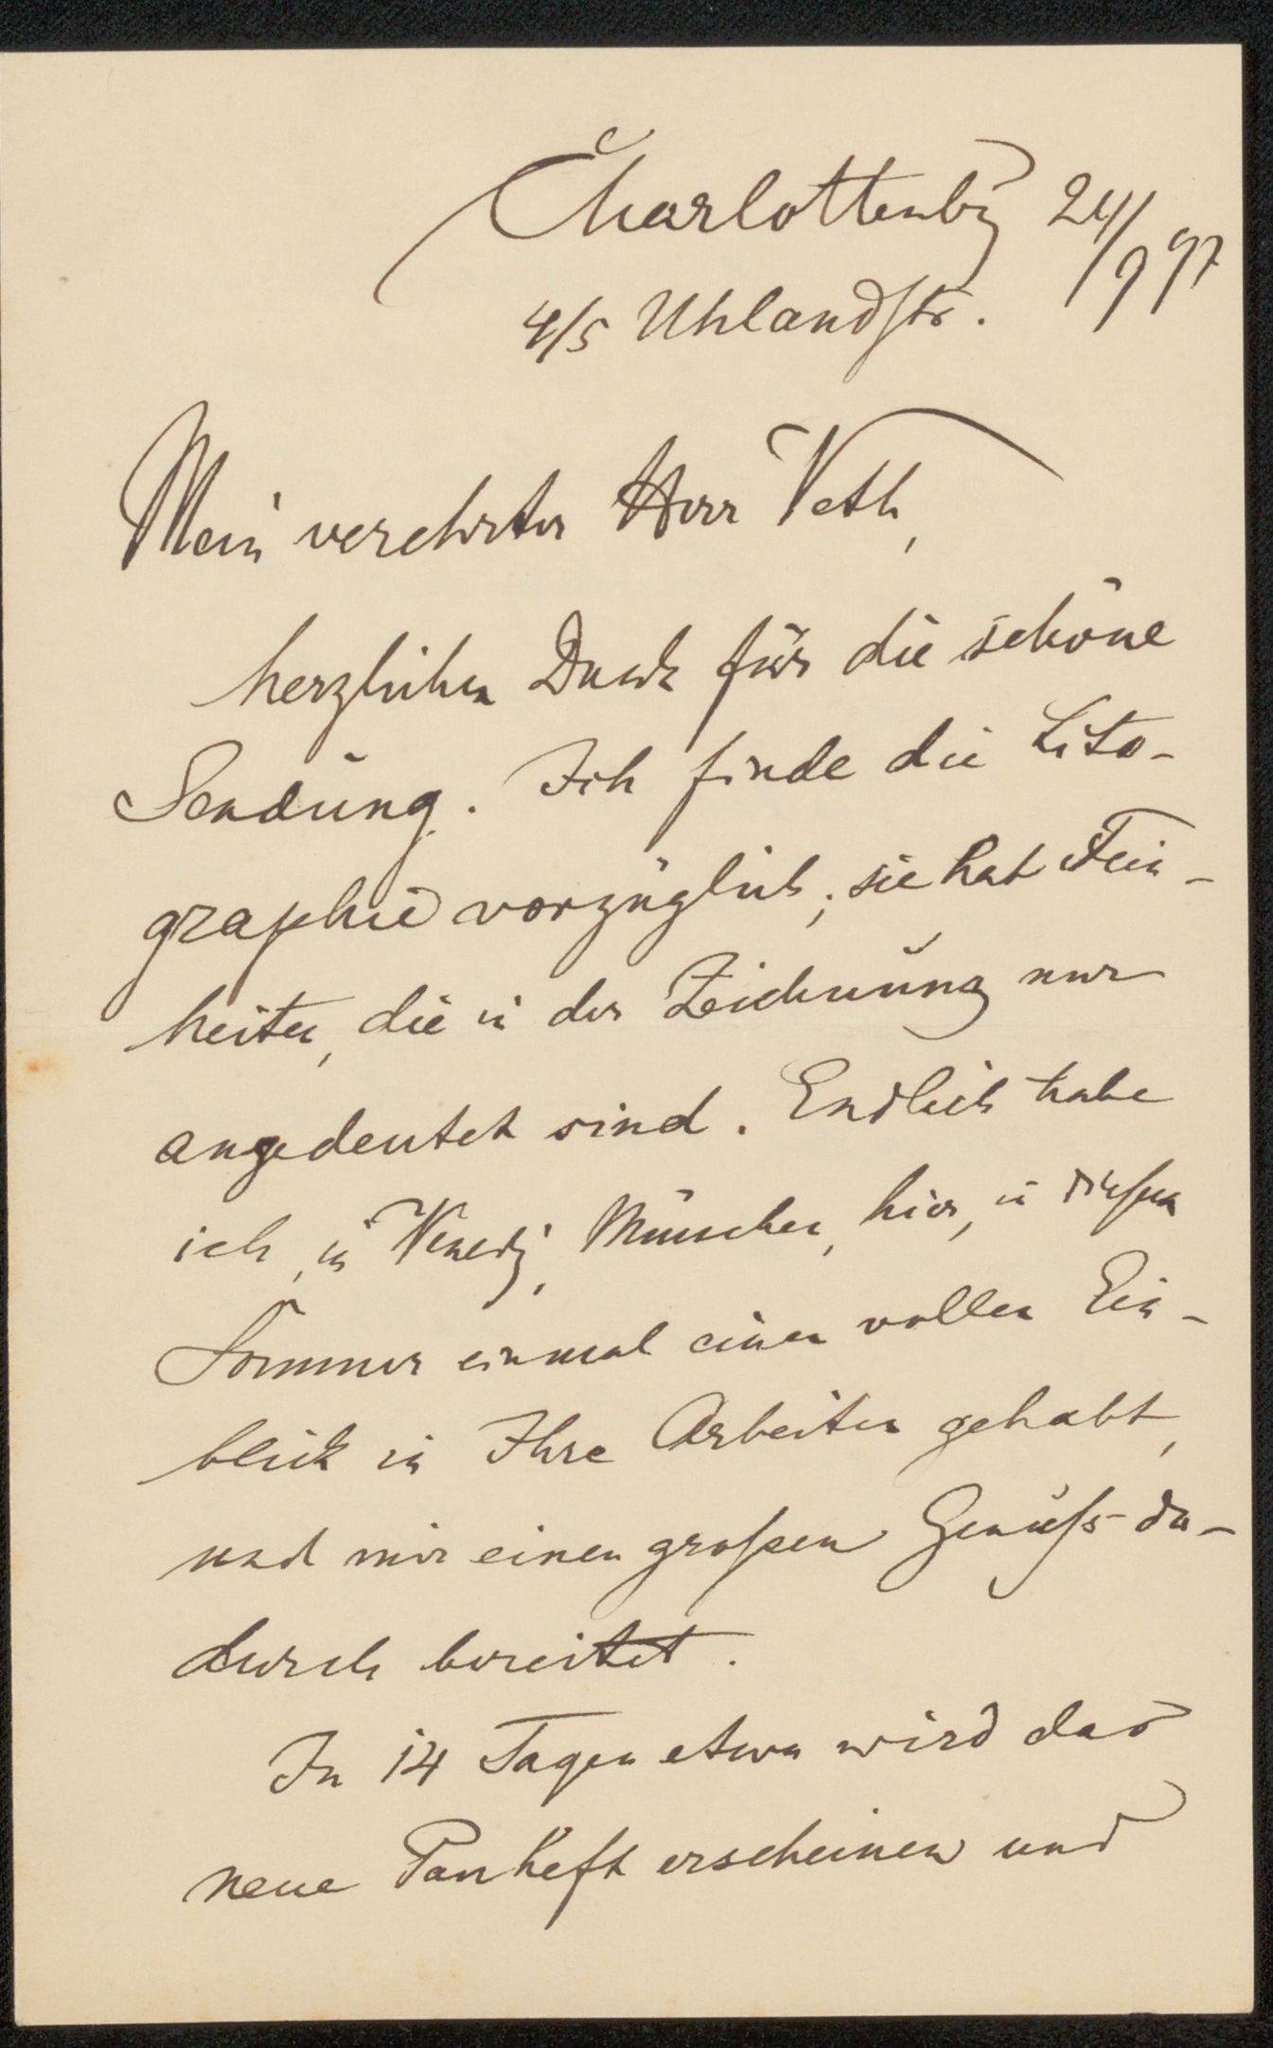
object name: letter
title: Brief aan Jan Veth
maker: wilhelm von bode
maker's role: conservator, kunsthistoricus, museumdirecteur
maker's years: 1845-1929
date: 1897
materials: ink, paper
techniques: pen, writing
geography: charlottenburg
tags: jozef israëls, jan veth, ludwig von hofmann, amsterdam, painter, draughtsman, rembrandt van rijn, print maker, otto eckmann, drawing, the graphic arts, exhibition ~ art, berlin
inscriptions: collector's mark: ‘RPK’